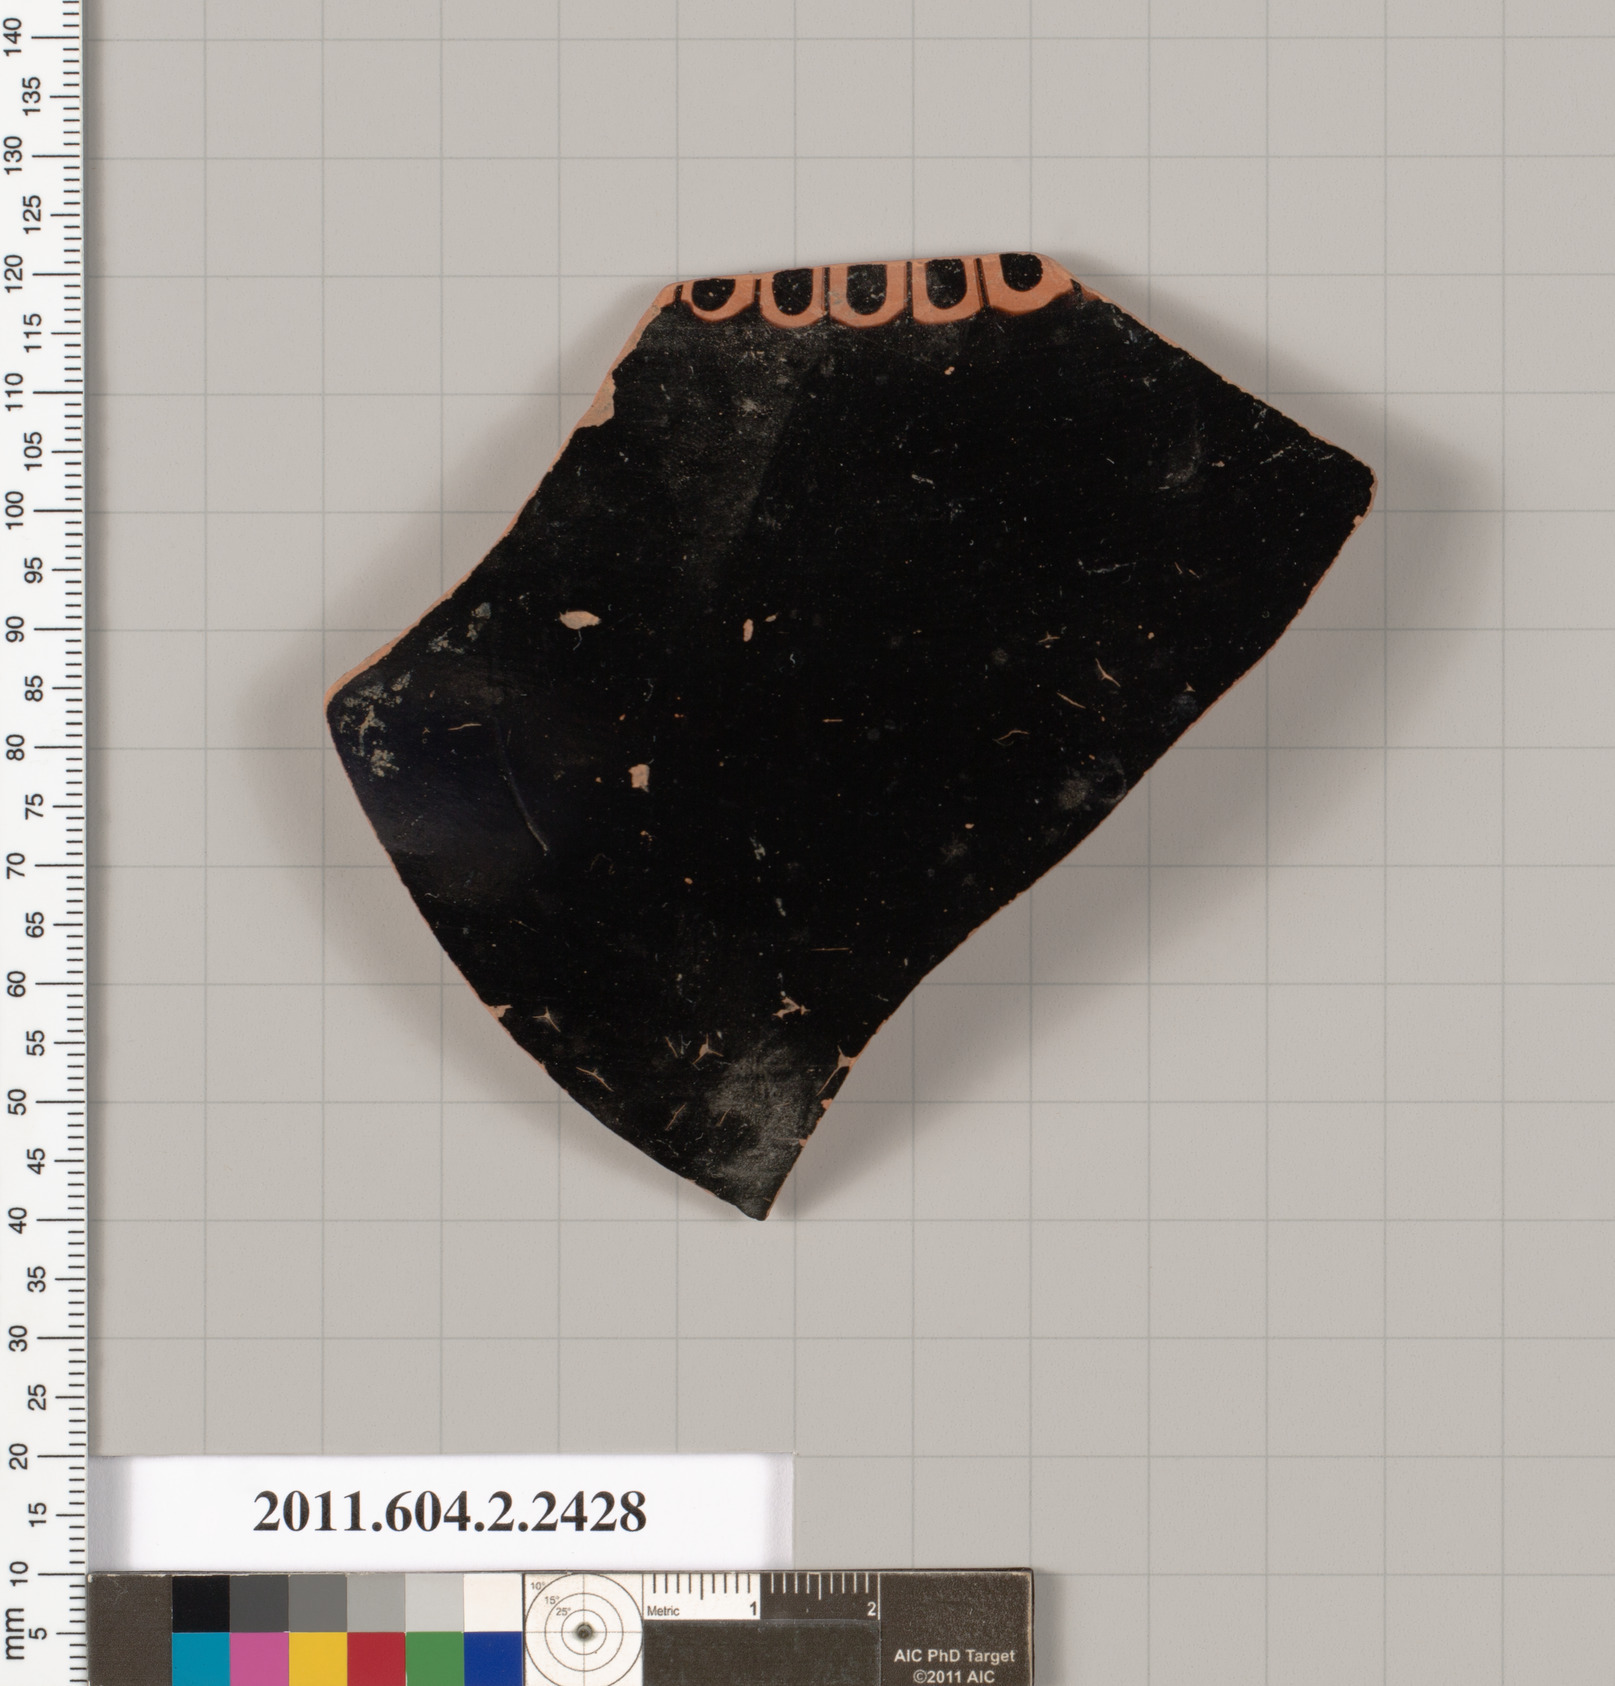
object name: amphora fragment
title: Terracotta fragment of an amphora (jar)?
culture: greek, attic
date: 500-401 BCE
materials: terracotta